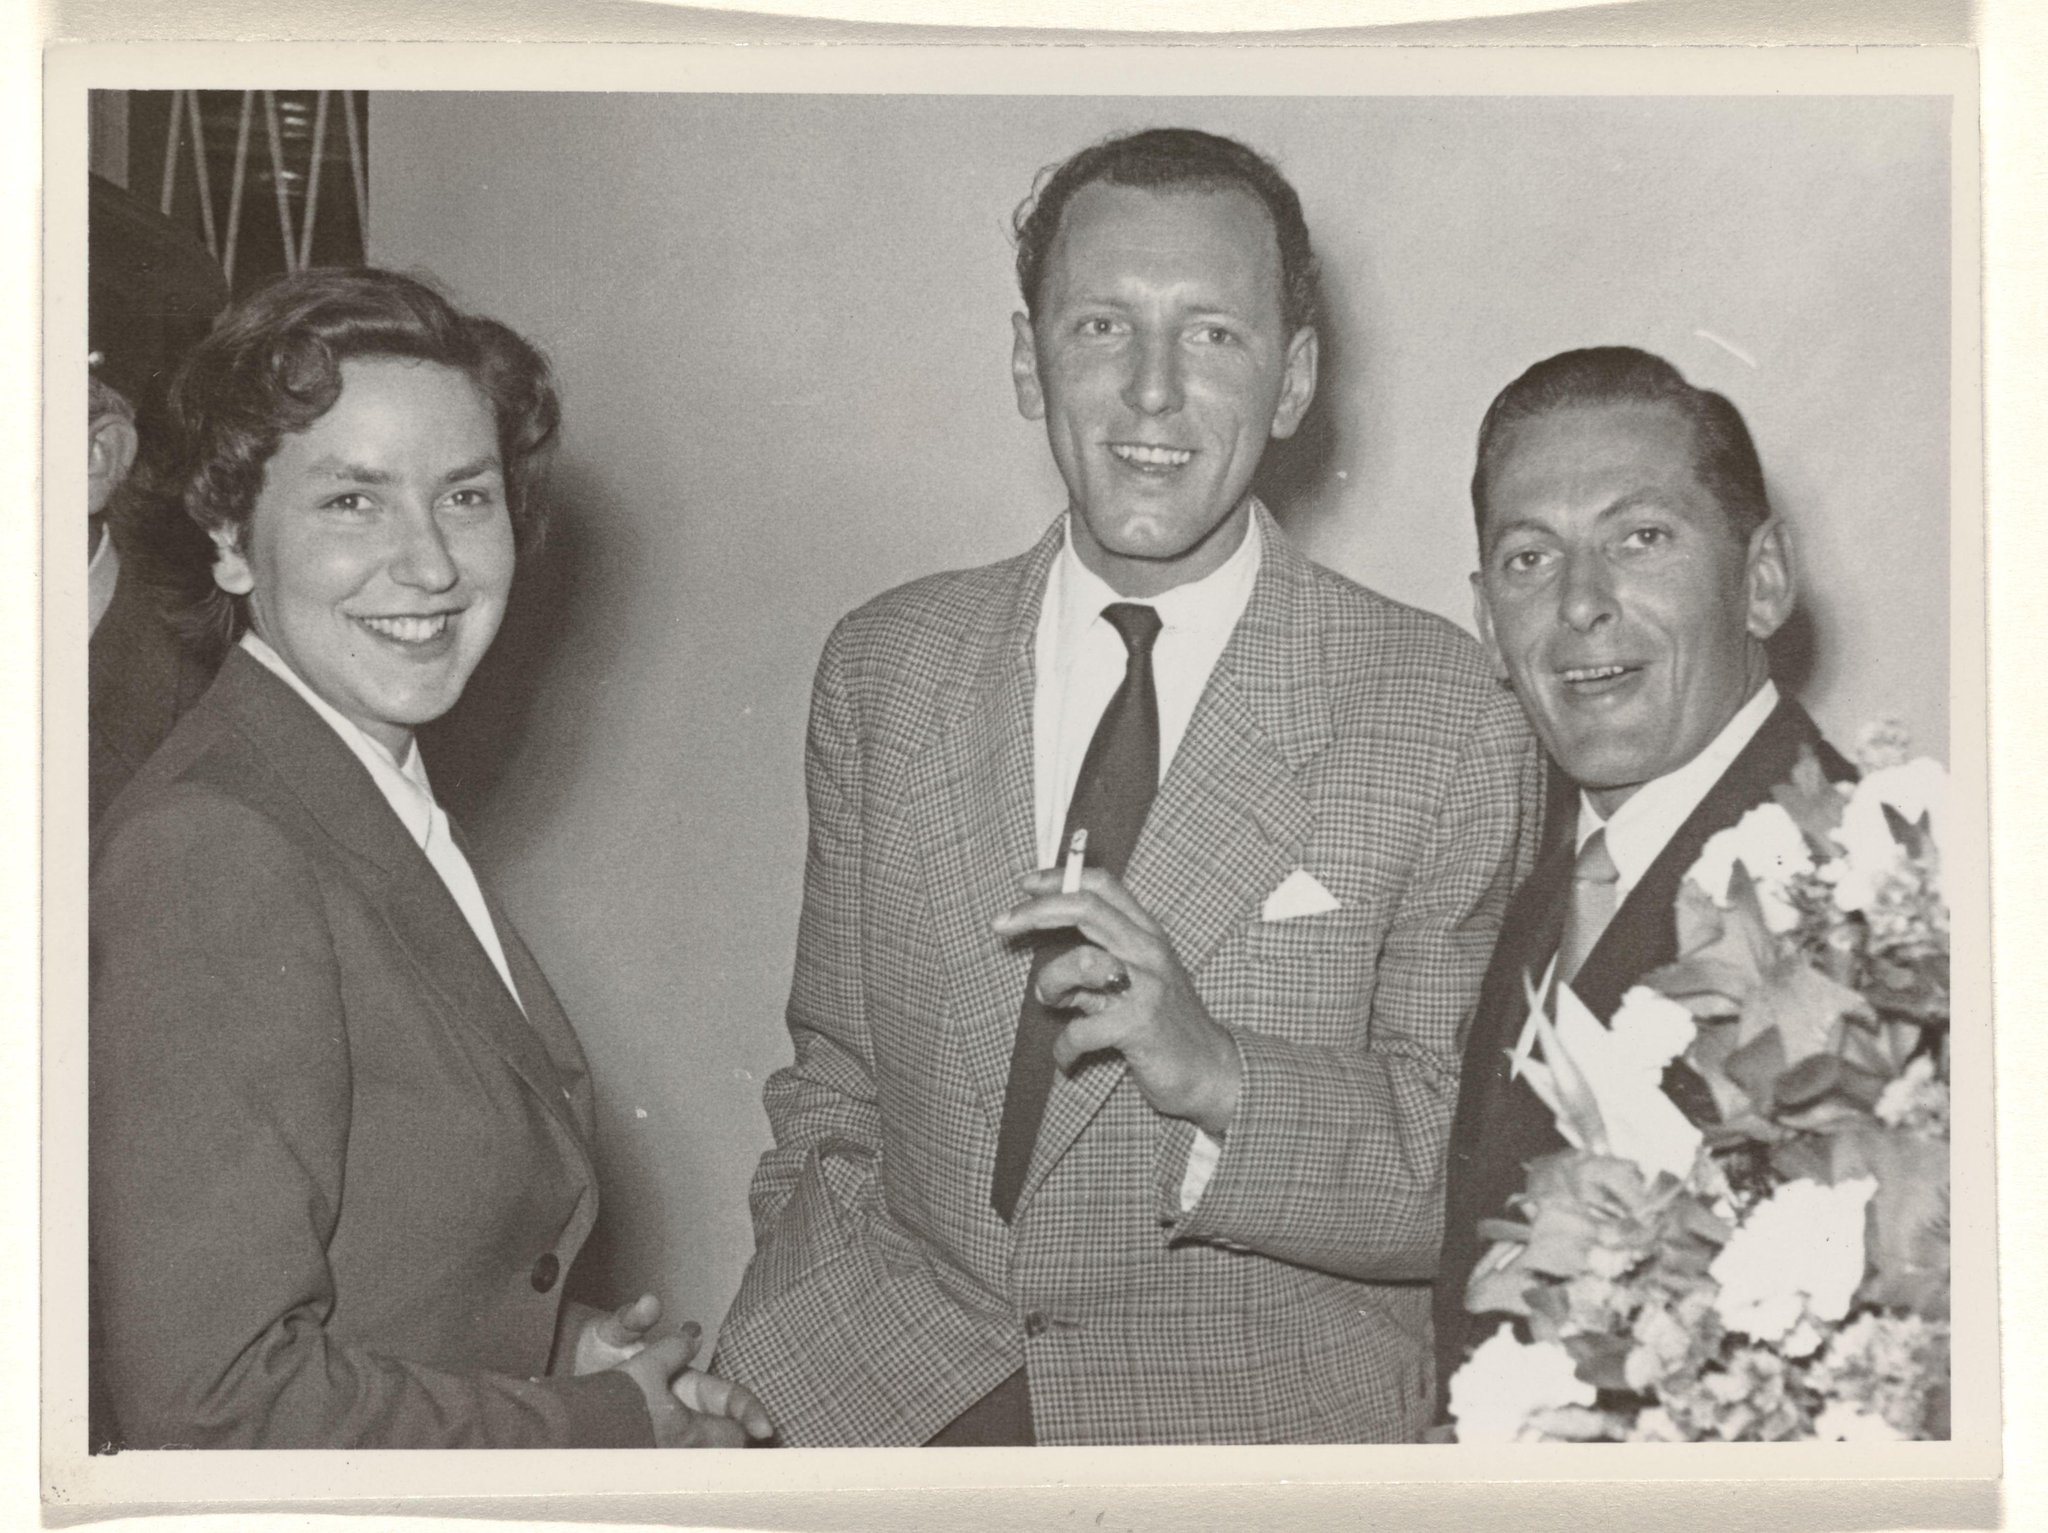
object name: photograph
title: Gideon Elon met een onbekende man en een onbekende vrouw, tijdens een receptie gedurende de KLM-tijd van Isabel Wachenheimer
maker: Anonymous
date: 1956-1973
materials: photographic support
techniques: gelatin silver print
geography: israel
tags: gideon elon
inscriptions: number: ‘1683/31 Copyright by photo-attar (at the yard), 16, Mendele St. Tel-Aviv, Israel’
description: Gideon Elon (rechts) met een onbekende man en een onbekende vrouw, tijdens een receptie.